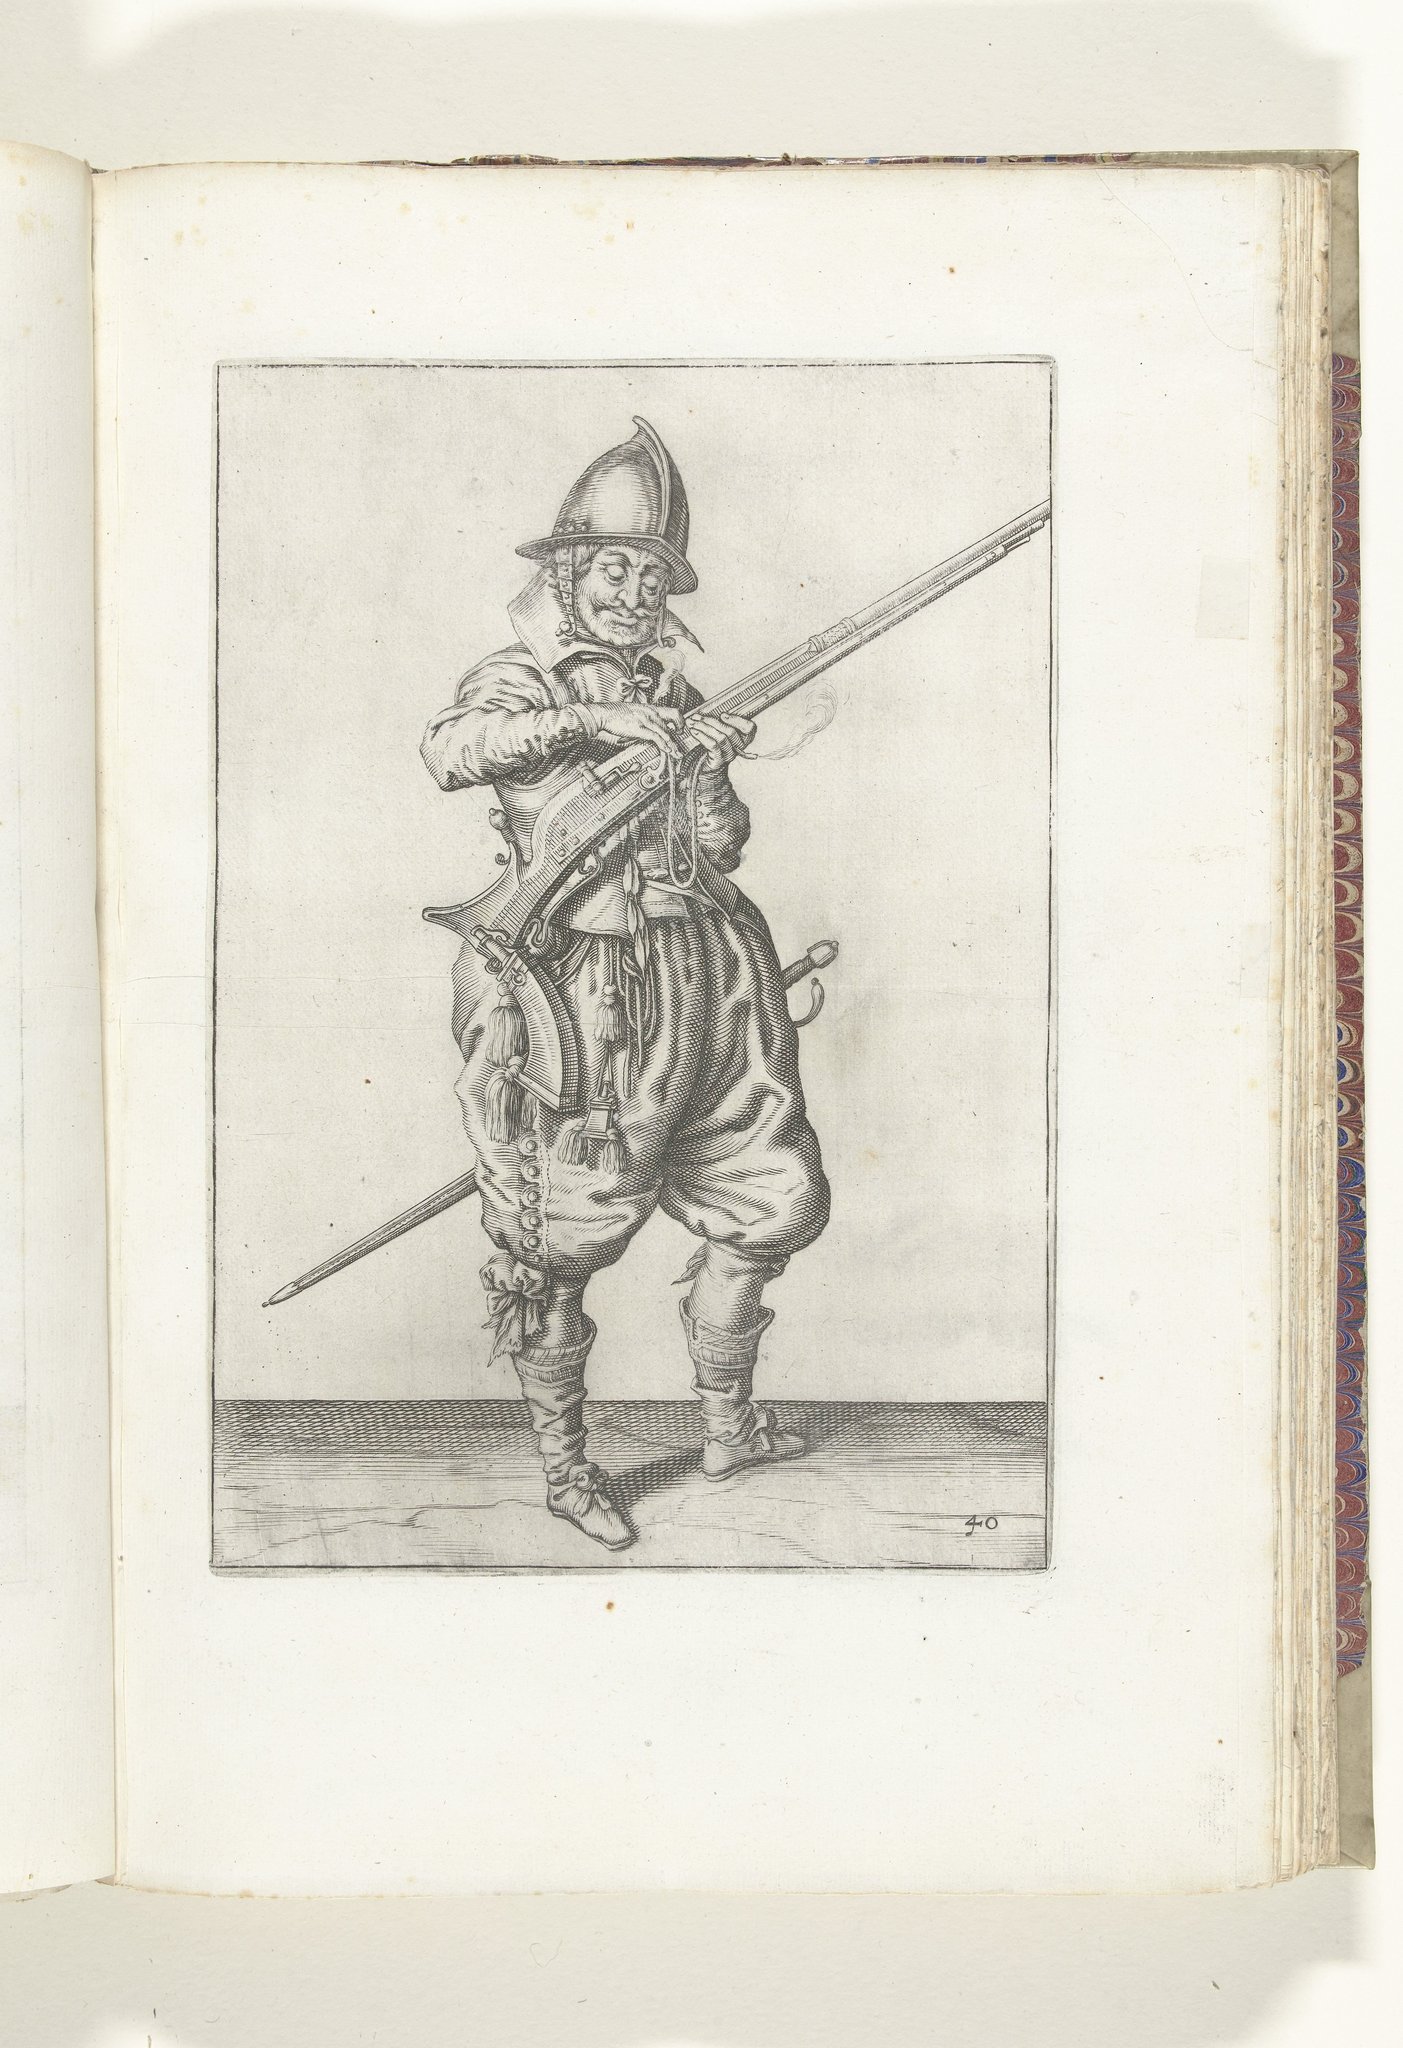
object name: print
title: Soldaat op wacht die zijn lont op de haan van zijn roer drukt (nr. 40), ca. 1600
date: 1597-1607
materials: paper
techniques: engraving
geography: northern netherlands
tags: maurice (prince of orange), handling of weapons ~ military training, weapons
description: Een soldaat op wacht, ten voeten uit, naar rechts, die een roer (een bepaald type vuurwapen) met zijn linkerhand vasthoudt (nr. 40), ca. 1600. Met zijn rechterhand drukt hij een brandende lont op de haan (onderdeel van het ontstekingsmechanisme) van zijn roer. Het gaat dus om dezelfde positie als degene die op de zevende prent van de serie getoond wordt. Plaat 40 in de instructies voor het hanteren van de roer. Onderdeel van de illustraties in: J. de Gheyn, Wapenhandelinghe van Roers Musquetten ende spiessen, Amsterdam, 1608. Krijgswezen rond 1600.